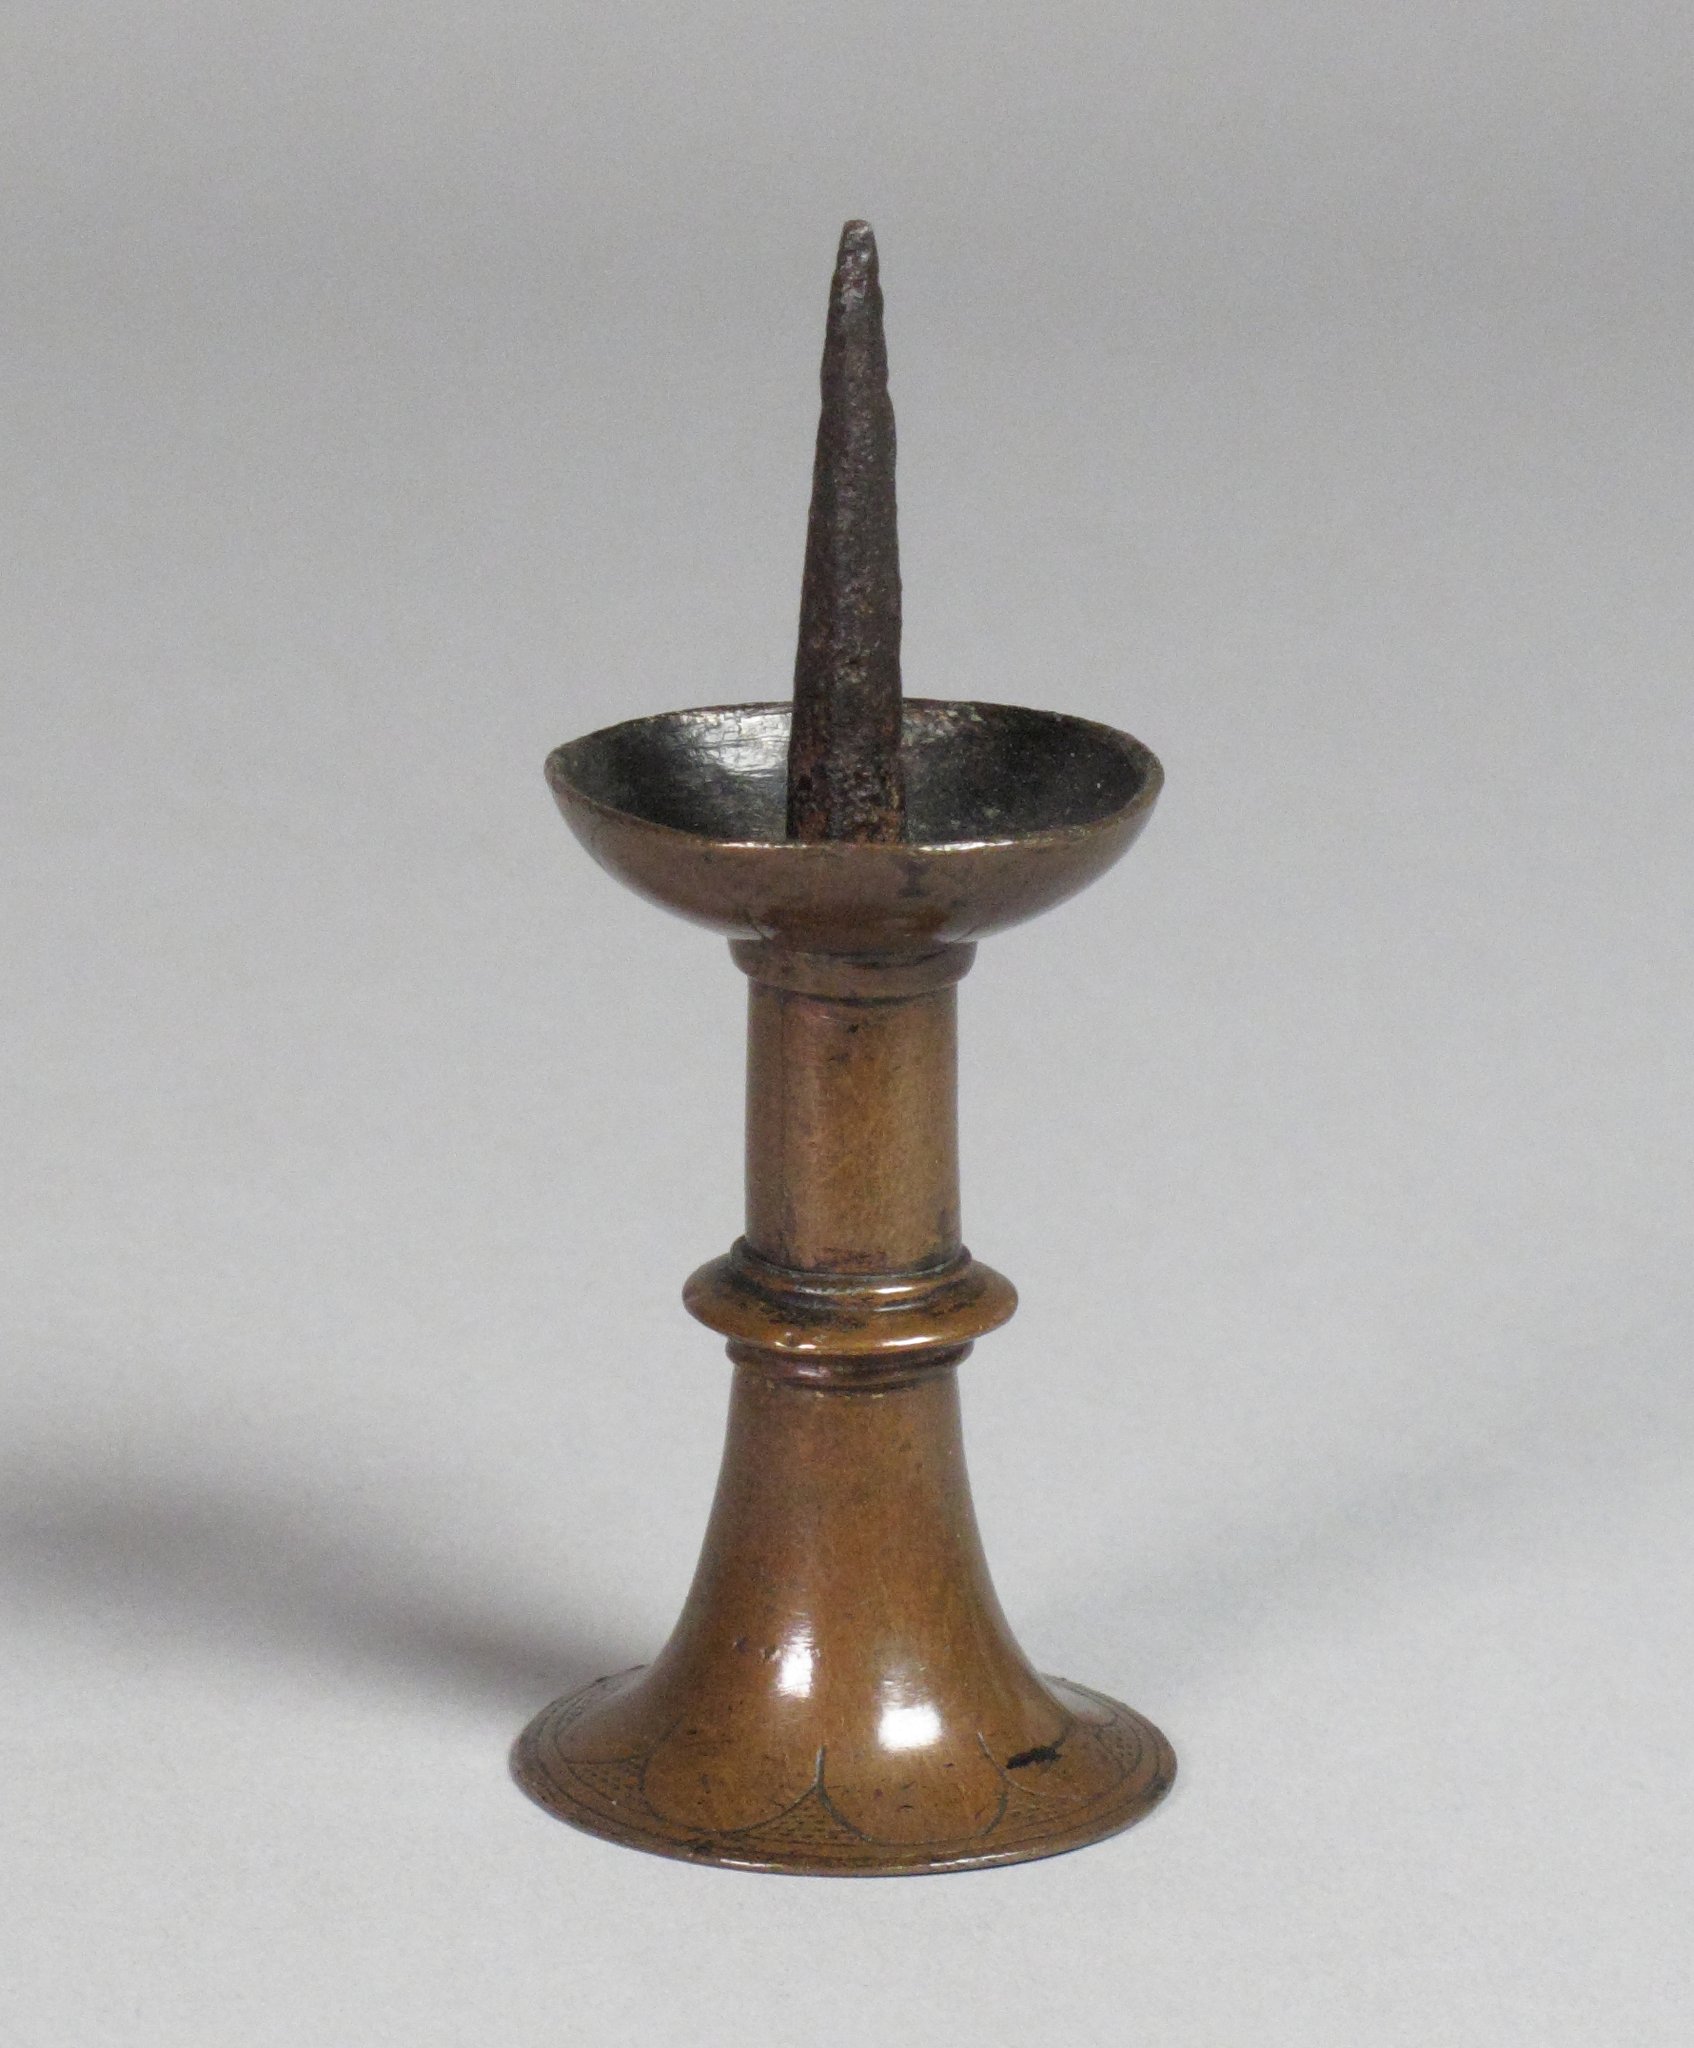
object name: candlestick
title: Pricket Candlestick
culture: british or northern european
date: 1201-1300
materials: copper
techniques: gilding